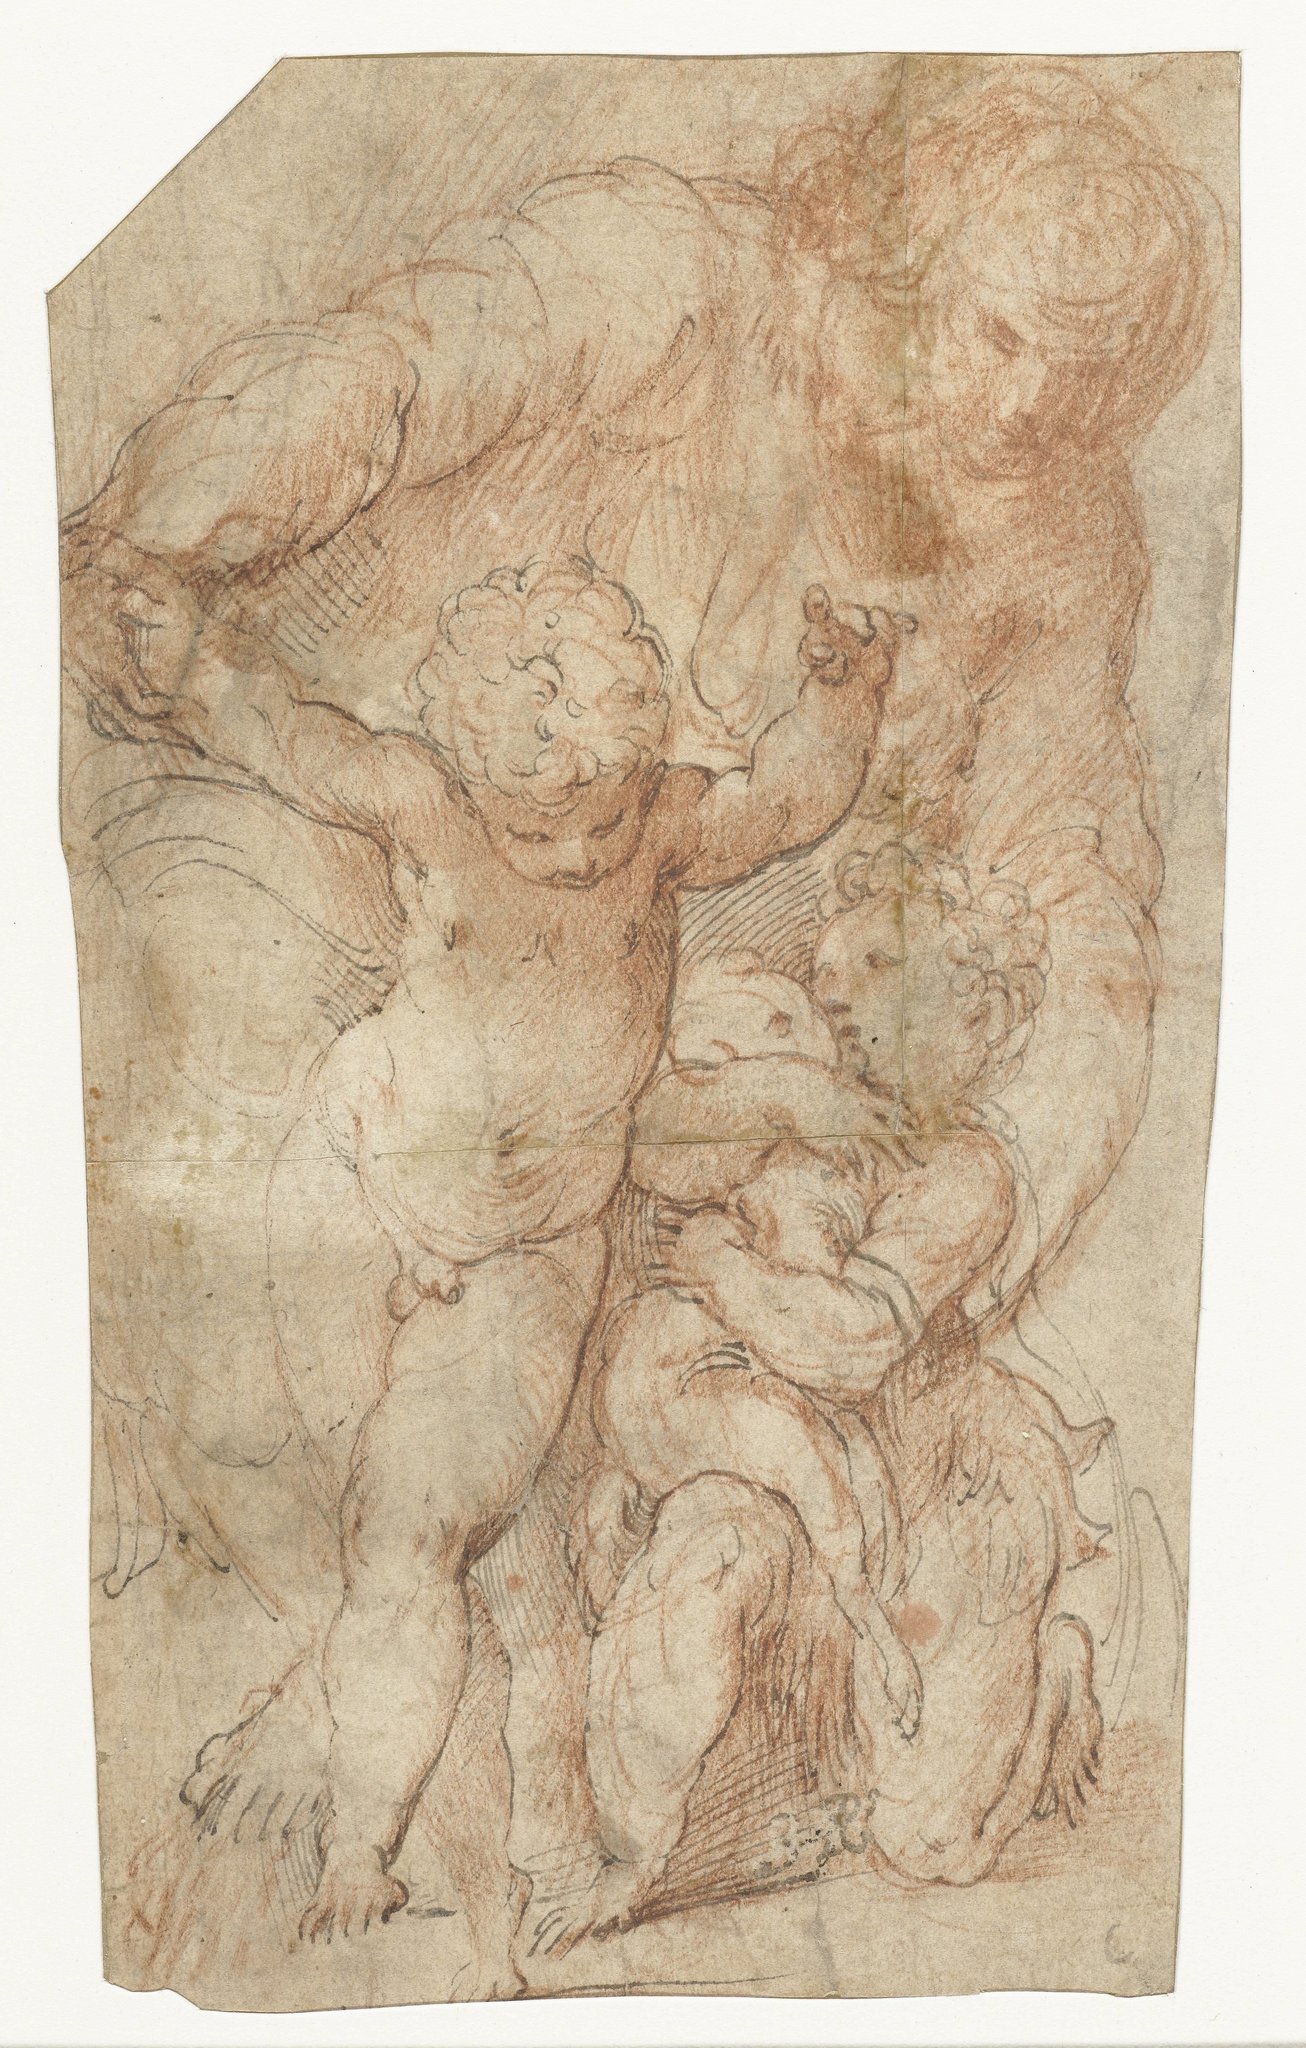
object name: drawing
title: Madonna met het Christuskind en de kleine Johannes de Doper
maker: parmigianino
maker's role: draughtsman, painter, print maker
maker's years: 1503-1540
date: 1526-1528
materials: chalk, ink, paper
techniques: pen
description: Voorstudie voor het schilderij "Het visioen van de Heilige Hieronymus" in de National Gallery te Londen.